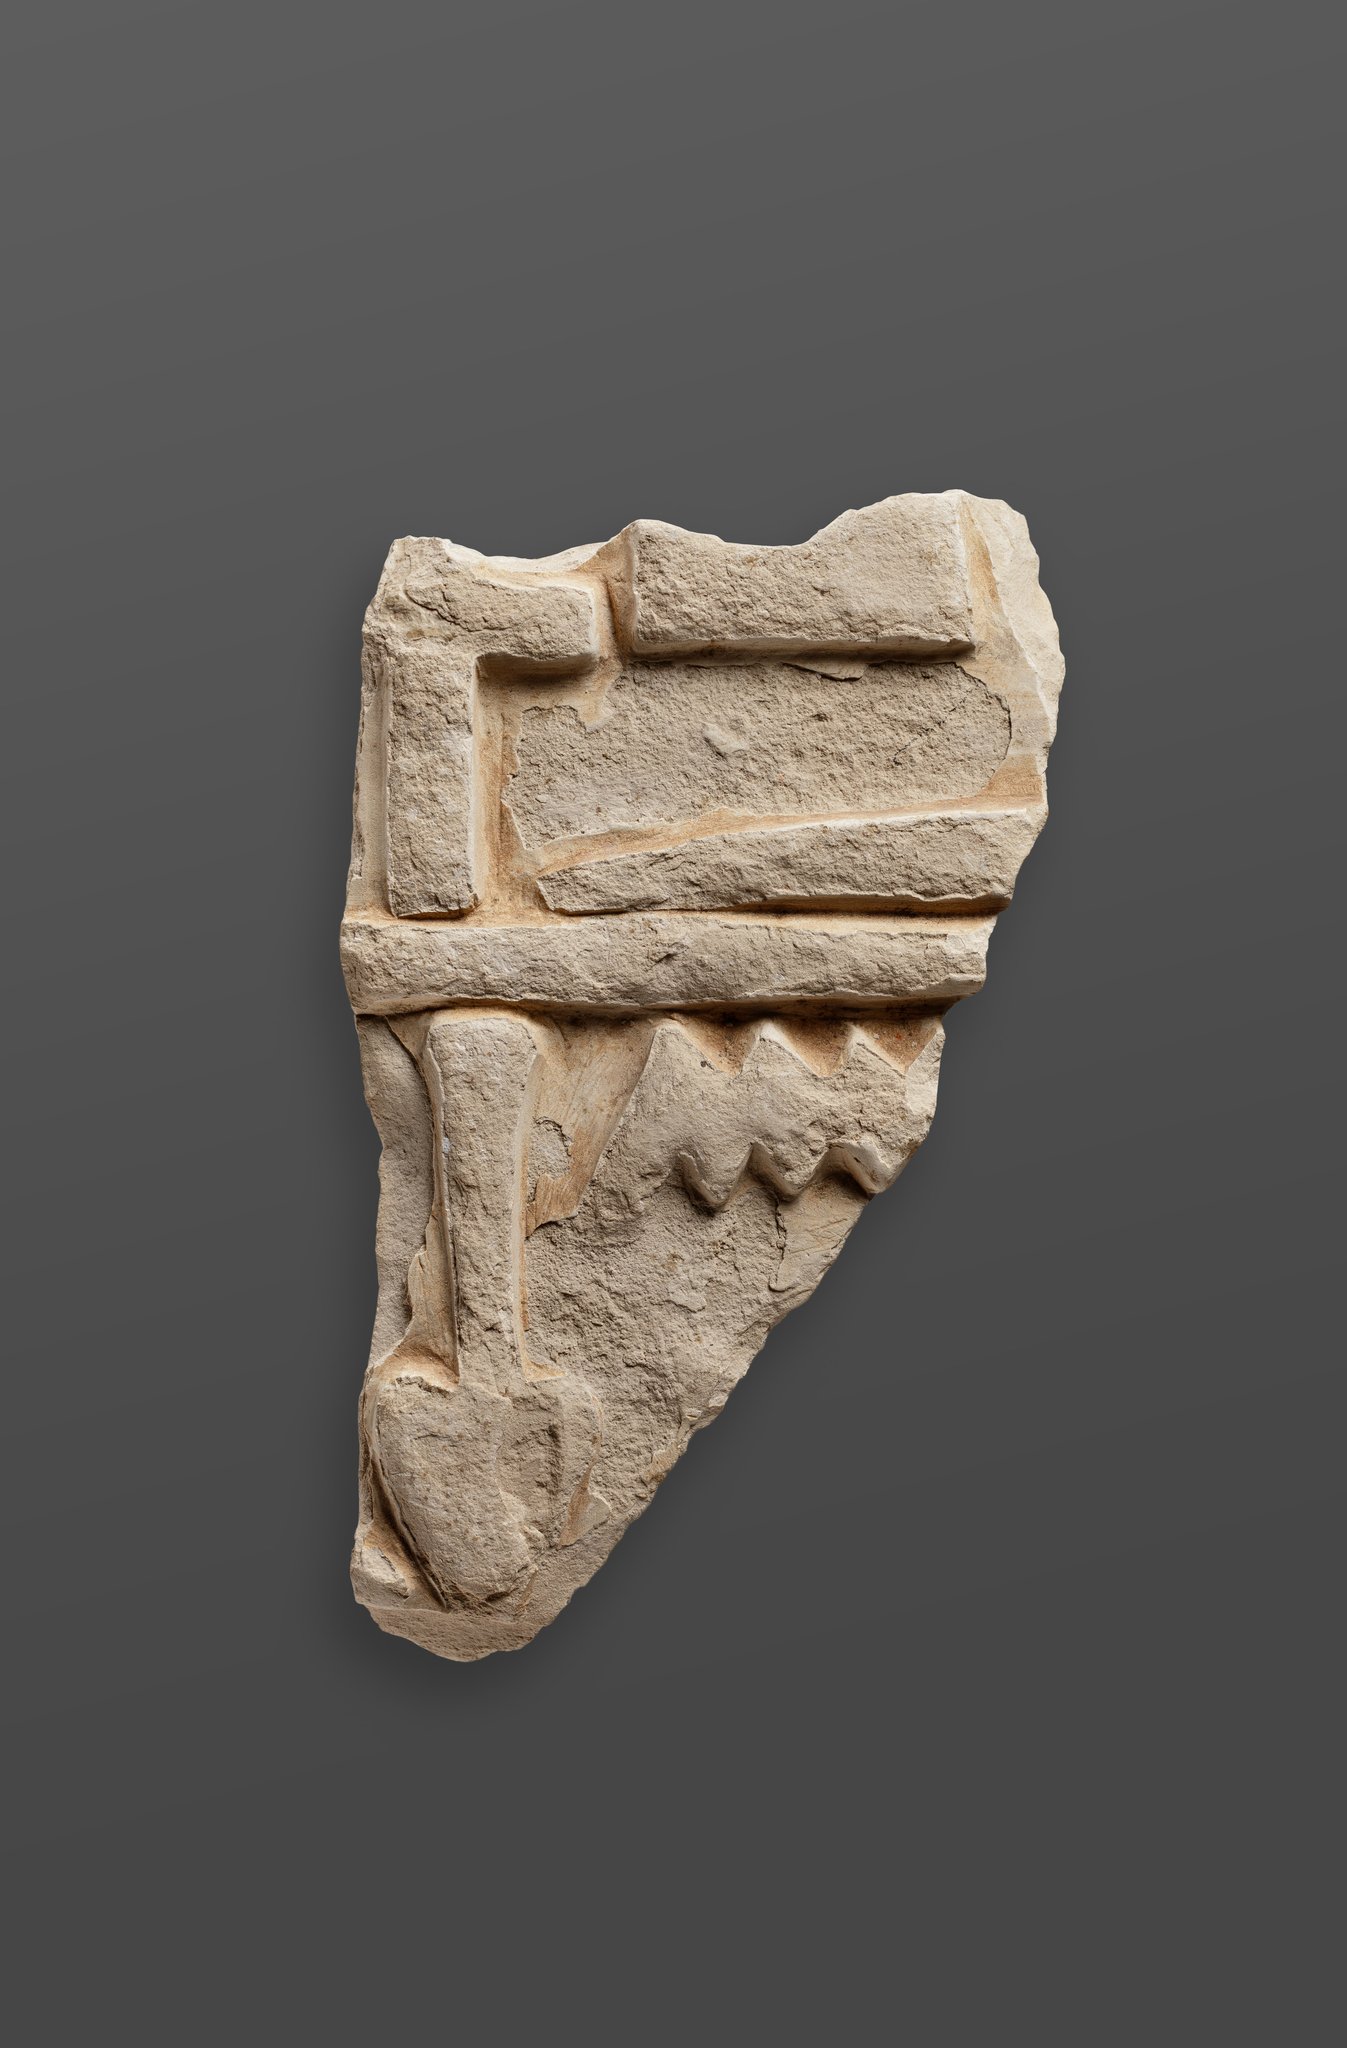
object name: relief fragment 1 of 2, tomb of mereri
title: One of Two Fragments of an Offering Inscription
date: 2100-2090 BCE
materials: limestone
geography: egypt